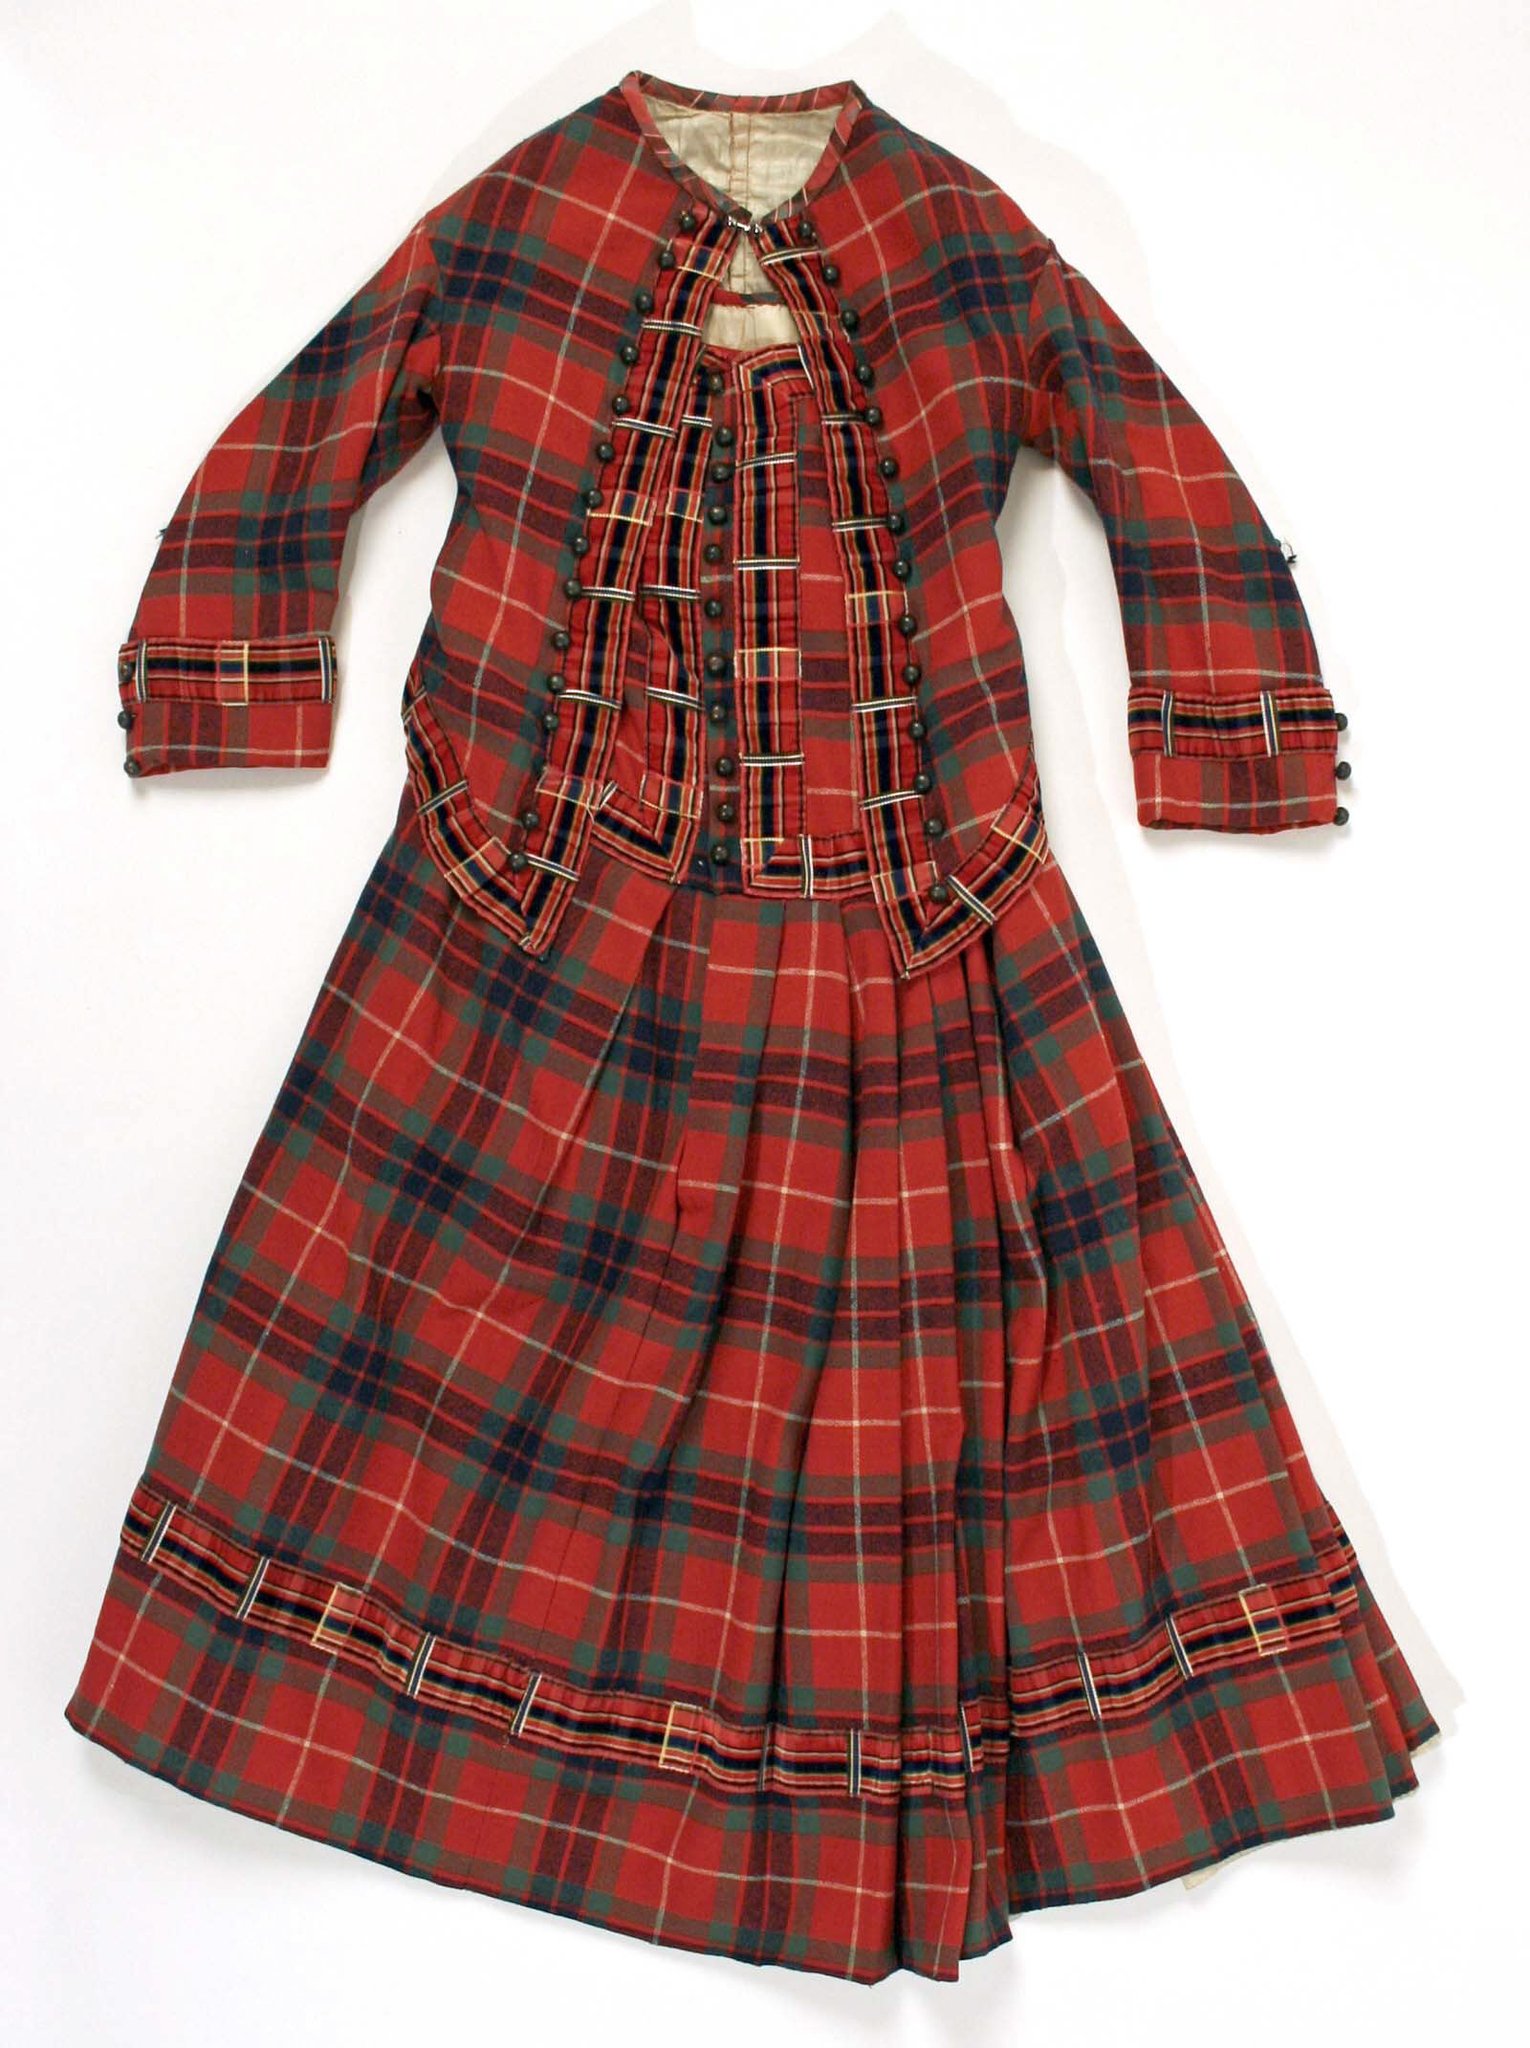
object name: ensemble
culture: british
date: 1860-1869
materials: wool